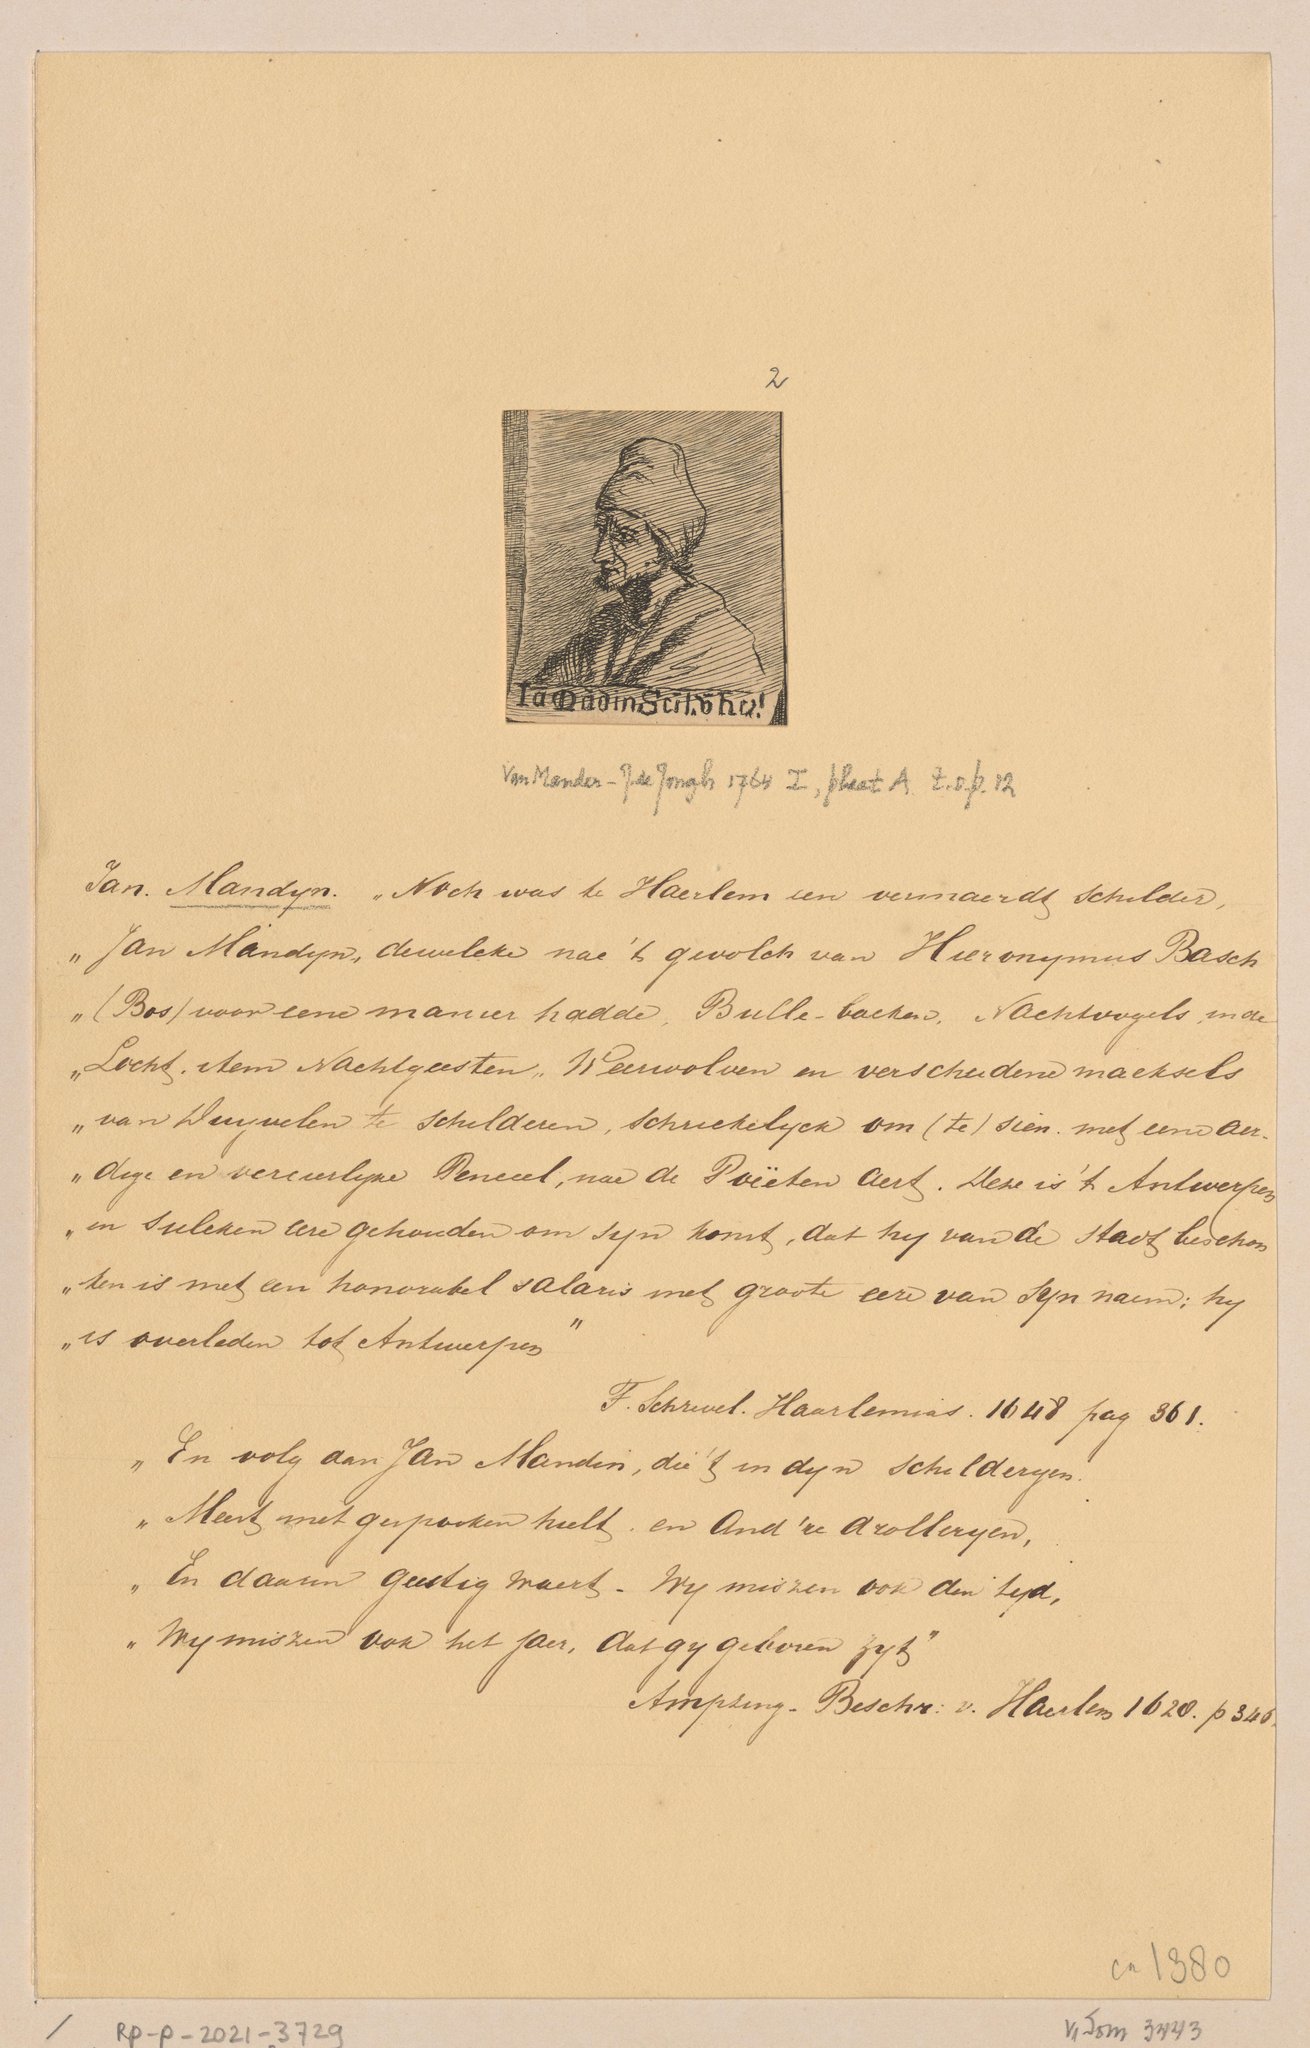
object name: book illustration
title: Portret van Jan Mandijn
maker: jan l admiral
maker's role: draughtsman, print maker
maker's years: 1699-1773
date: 1764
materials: paper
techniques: etching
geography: amsterdam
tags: historical persons, portrait, self-portrait of painter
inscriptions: inscription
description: Eerdere staat gebruikt in: Mander, Karel van. Het leven der doorluchtige Nederlandsche en eenige Hoogduitsche schilders. Amsterdam: Steven van Esveldt, 1764, dl. 1. Het portret is geknipt uit een prent met drie portretten, zie RP-P-1907-4247.